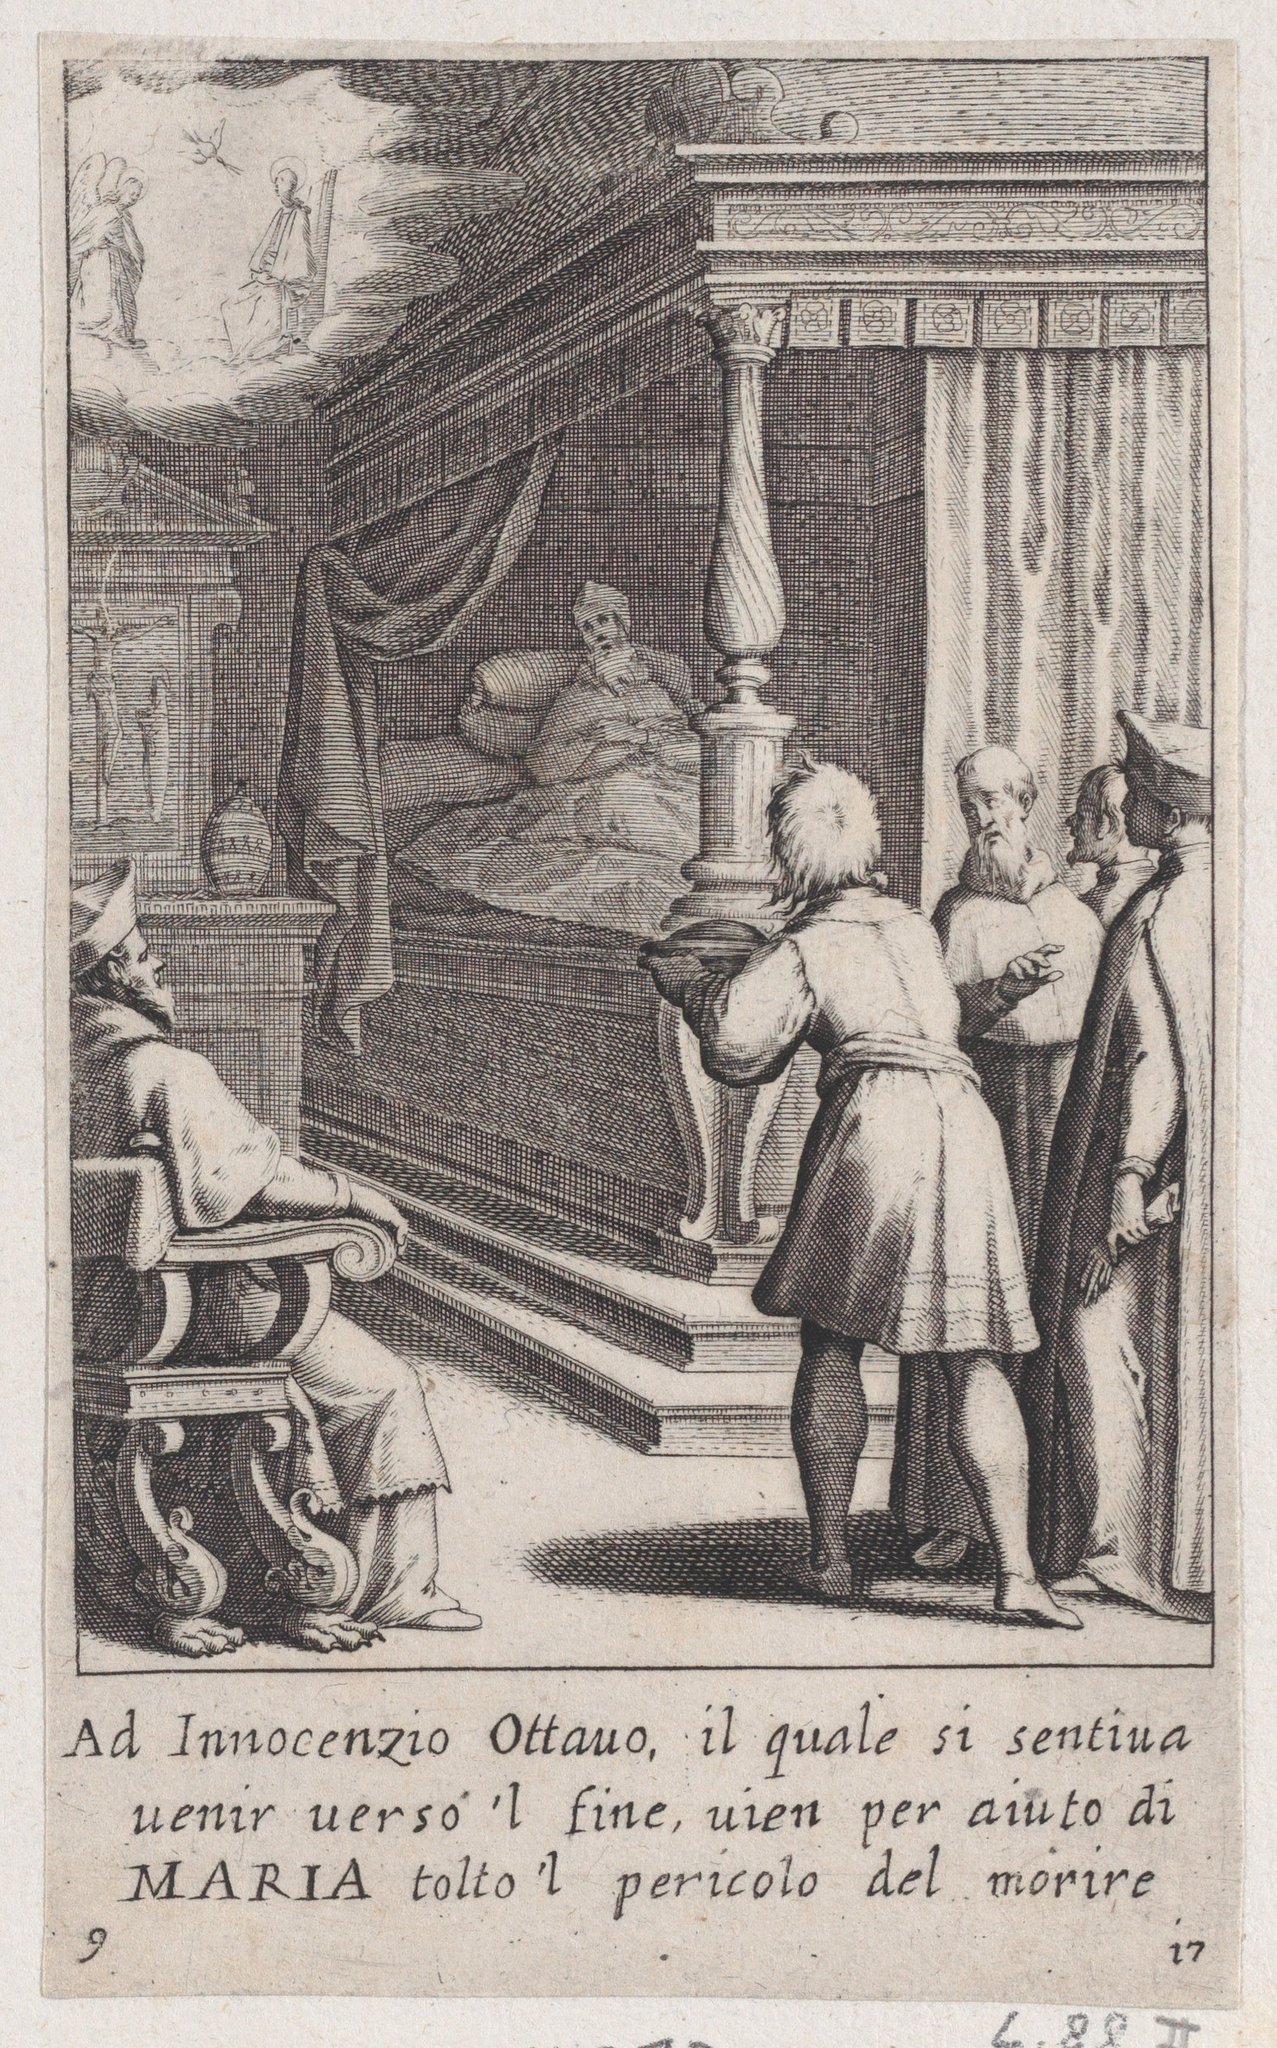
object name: print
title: Innocent VII, from Scelta d'Alcuni Miracoli e Grazie della Santissima Nunziata di Firenze (Selection of Some Miracles and Graces that Occurred in the Church of the Annunziata in Florence)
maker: jacques callot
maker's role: artist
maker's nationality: french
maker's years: 1592-1635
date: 1611-1619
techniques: engraving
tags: men,beds